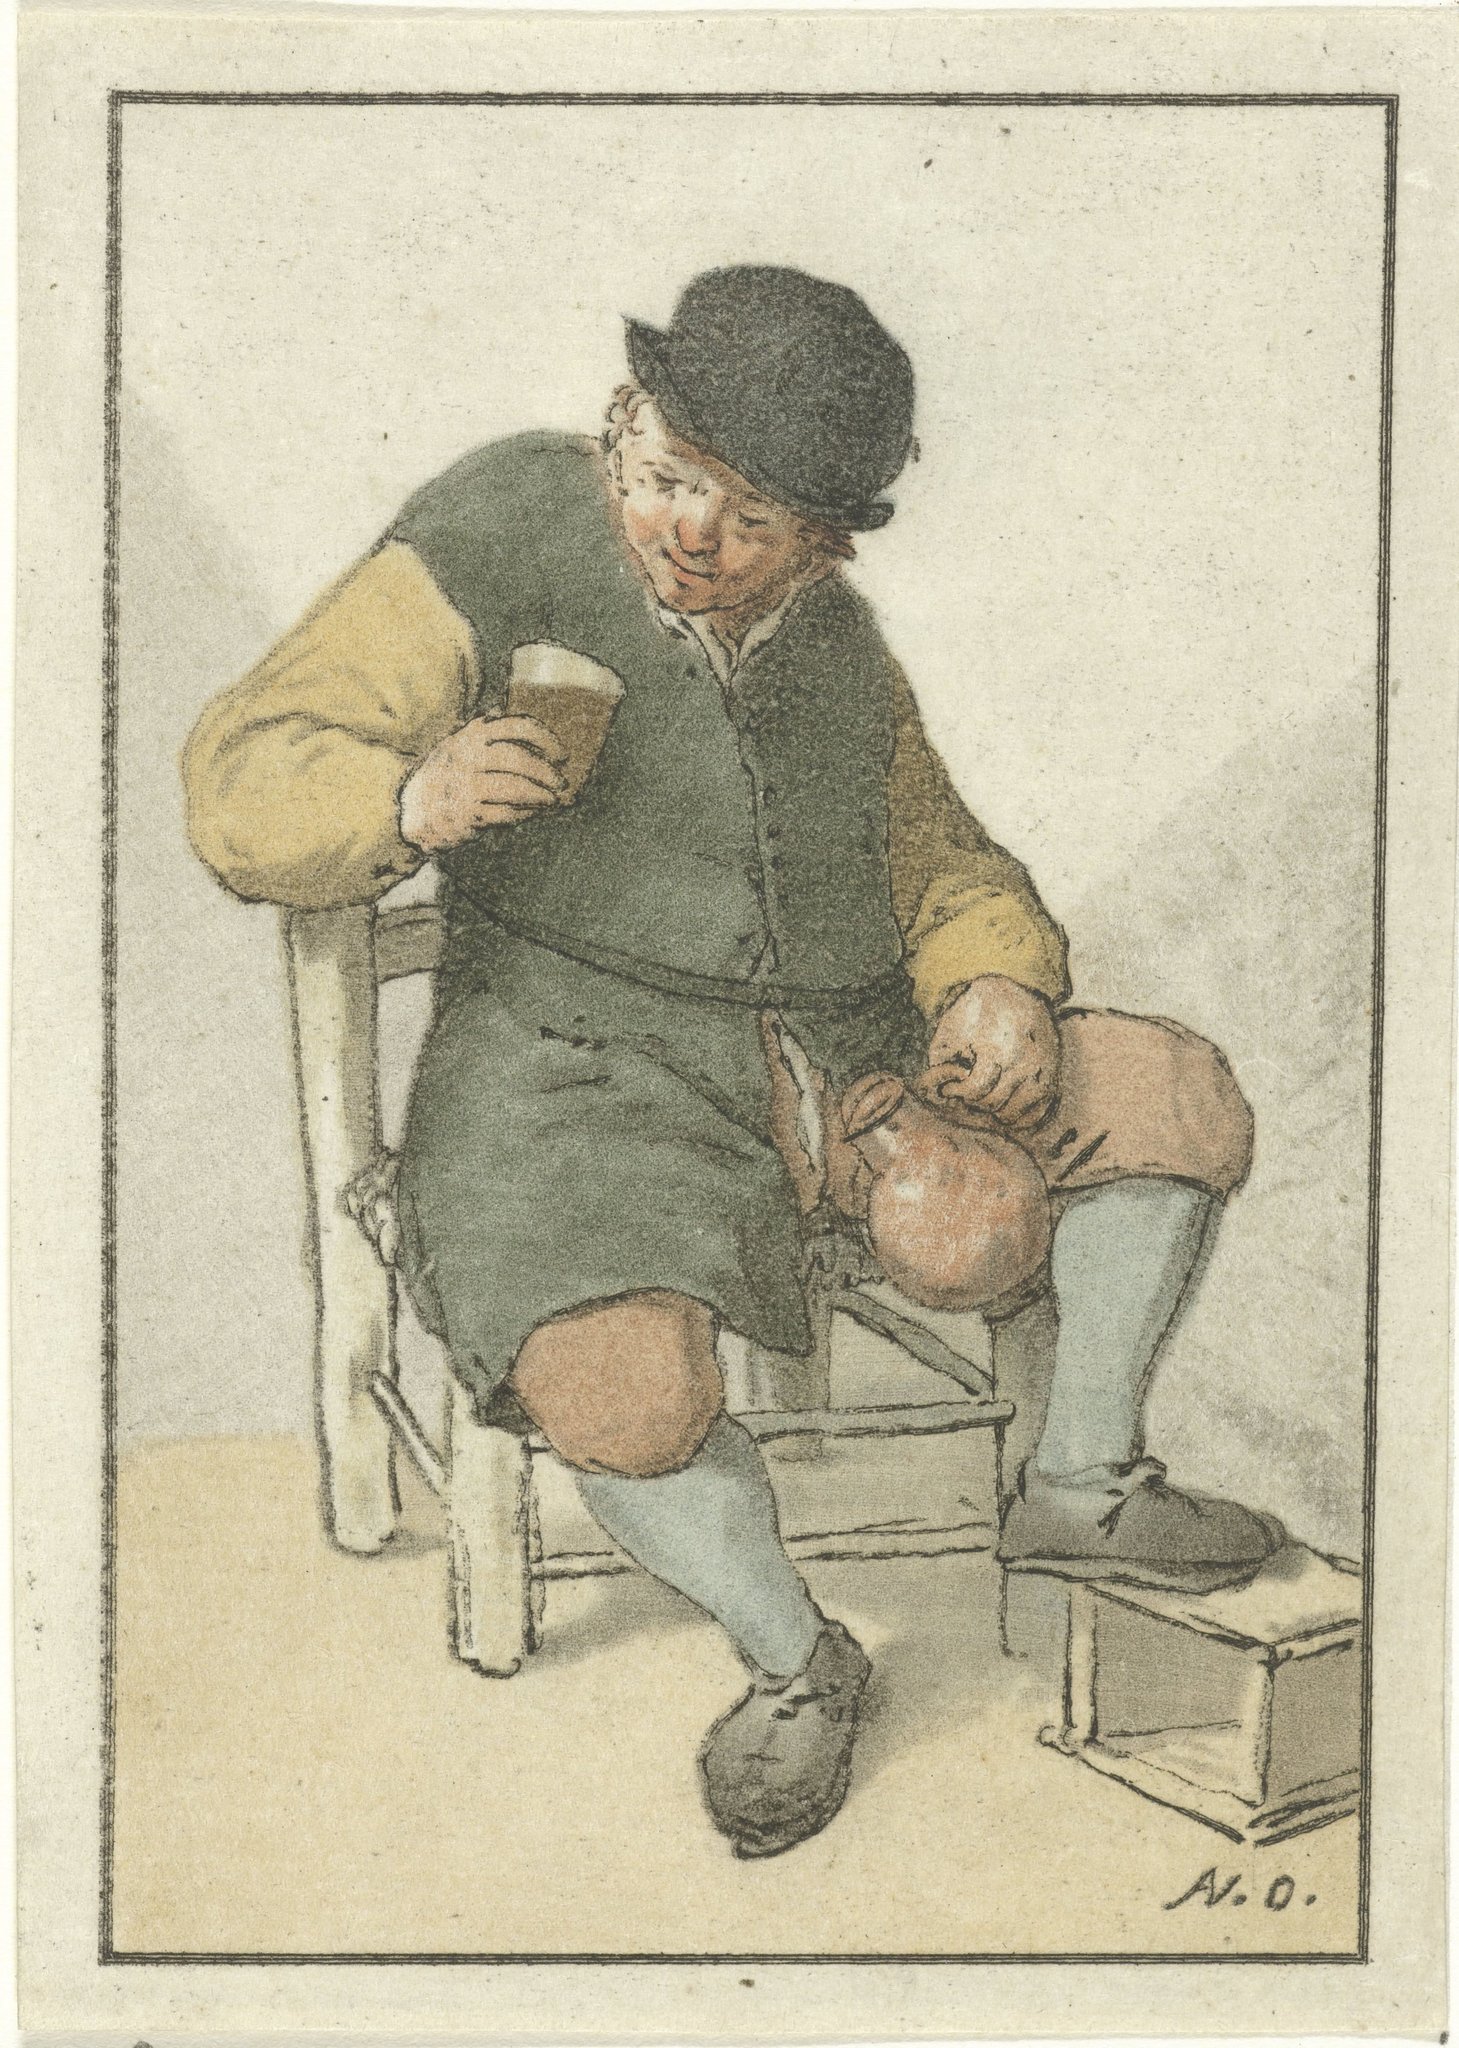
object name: print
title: Zittende boer met kruik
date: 1763-1768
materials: paper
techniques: roulette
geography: amsterdam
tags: sitting figure, jar, jug (used as drinking-vessel)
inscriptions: collector's mark: Lugt 2228, inscription: ‘Vereerd aan mij zeer geachte vriend! den Heere M J Vischerin 's hage 14 juny 1784 Ploos v Amstel / Ad: v Ostade del Ploos van Amstel JC Fecit gedrukt in kleur 8 oct 1768 zie getuigschrift’, collector's mark: Lugt 2725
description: Voor deze prenttekening, 'Zittende boer met kruik', maakte Ploos van Amstel vier verschillende platen (A, B, C, en D). Er bestaan afdrukken van één, twee, drie of alle vier de platen in alle mogelijke combinaties. Zie gerelateerde objecten voor de hier gebruikte platen.